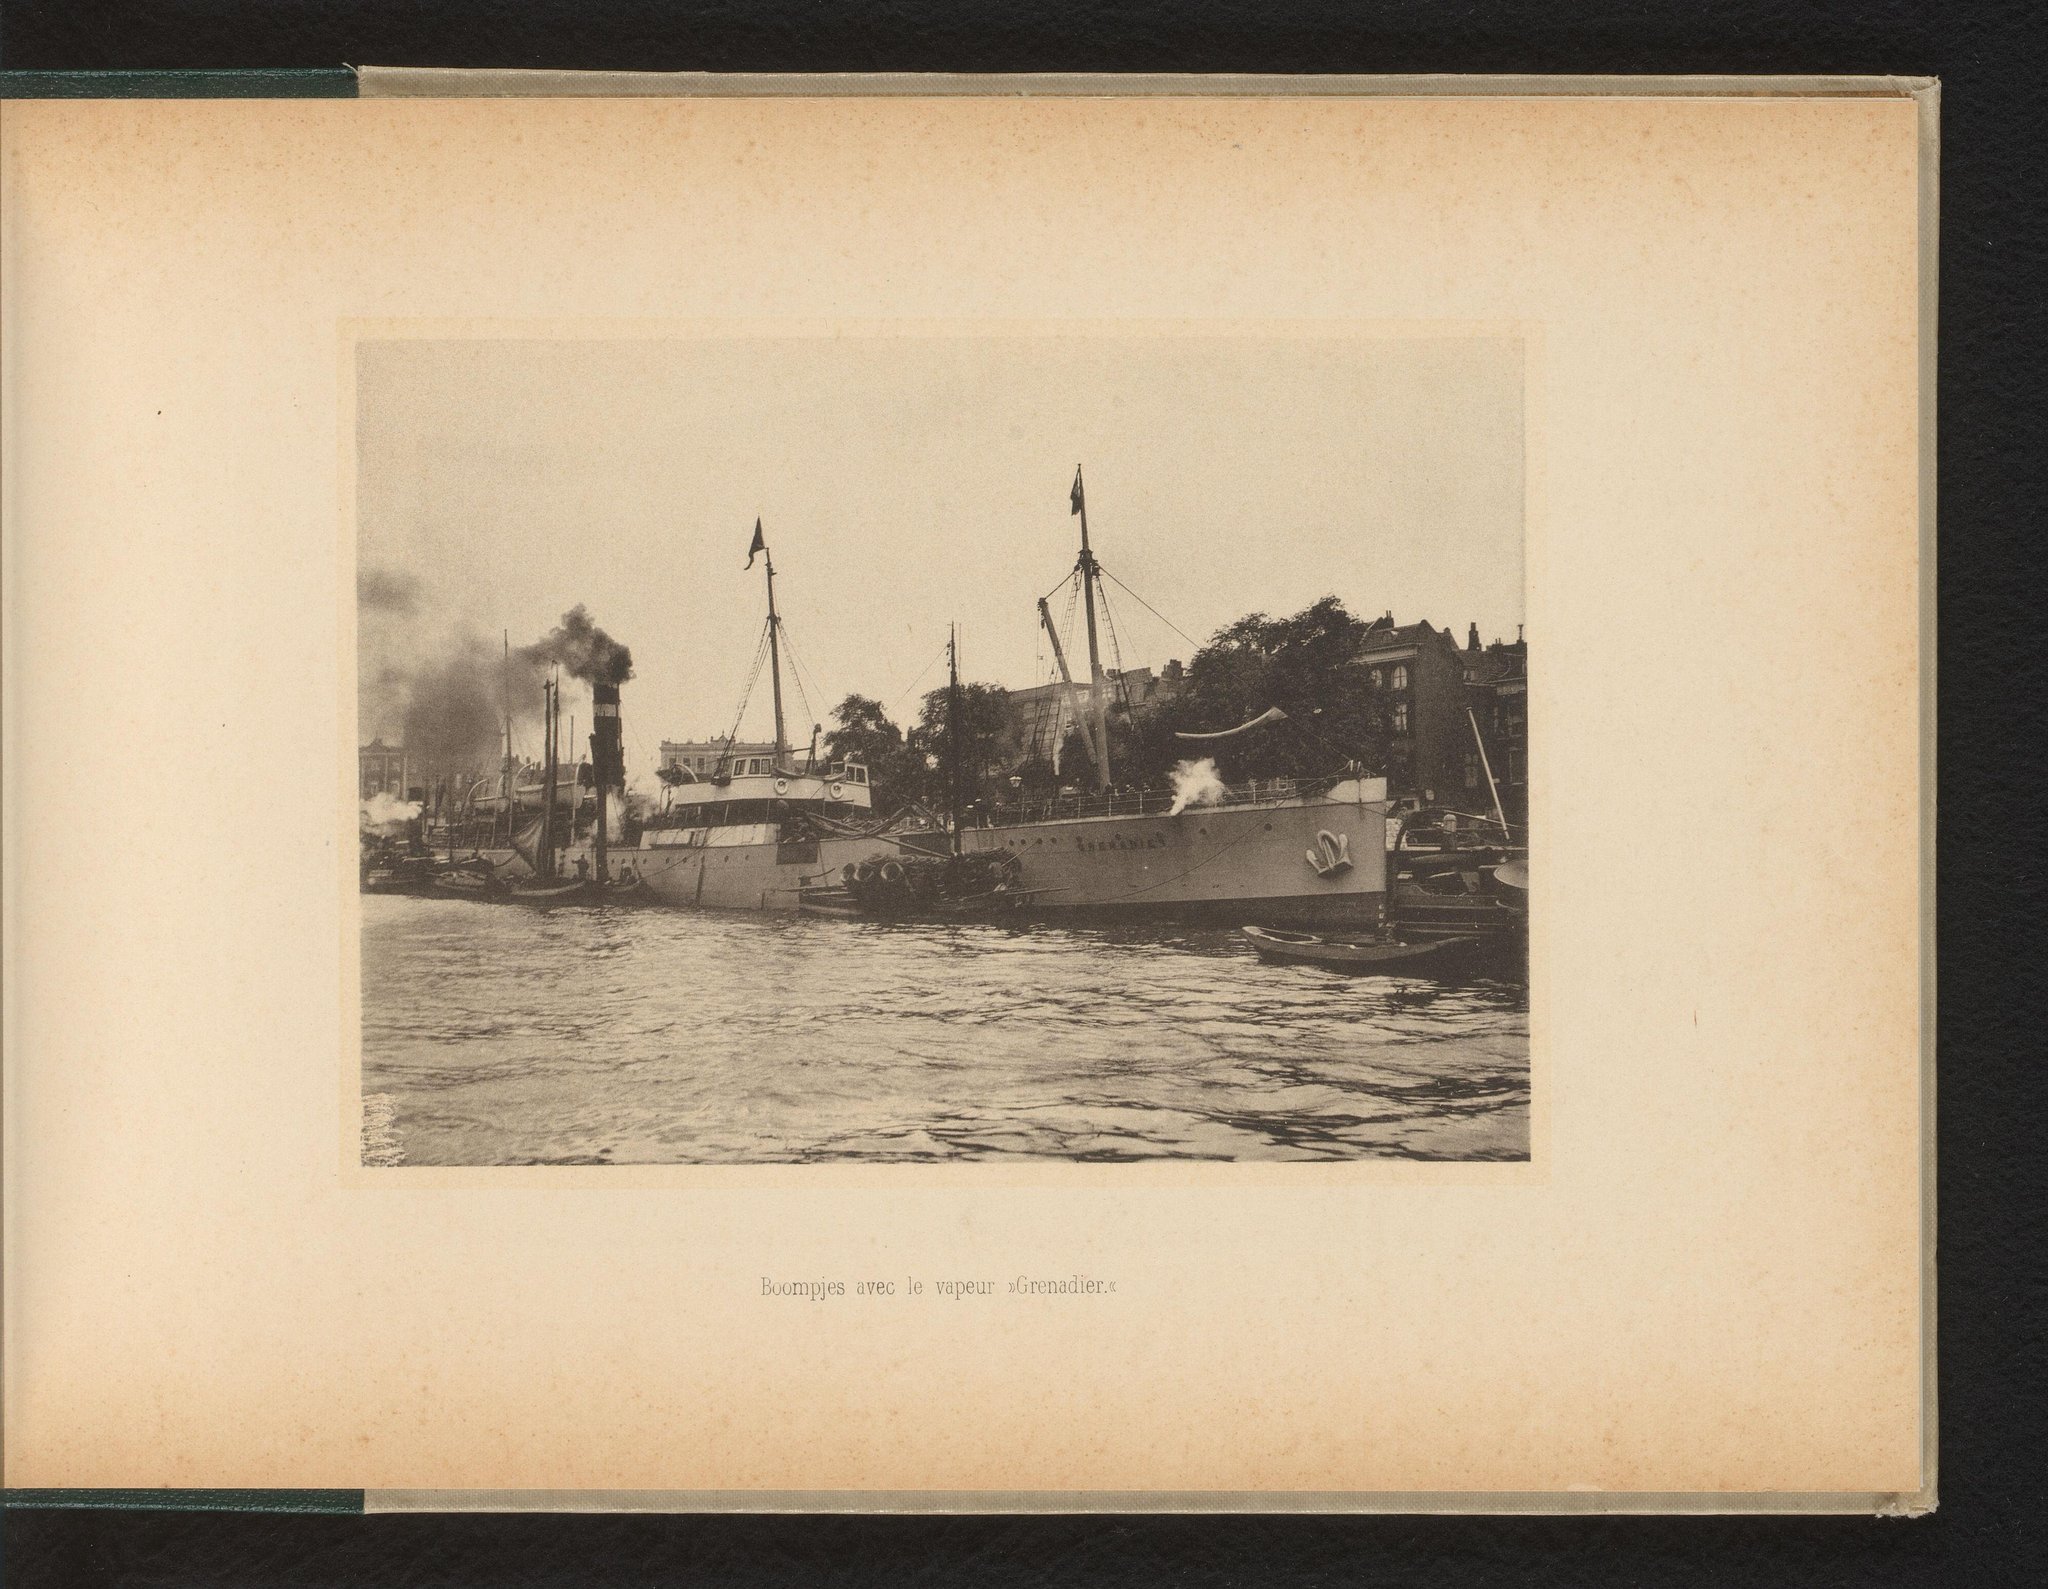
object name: photomechanical print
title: Gezicht op de Boompjes, met op de voorgrond het stoomschip Grenadier, Rotterdam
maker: Anonymous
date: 1902-1907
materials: paper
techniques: photograph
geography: rotterdam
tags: canals, waters (in city), steamship, motorship